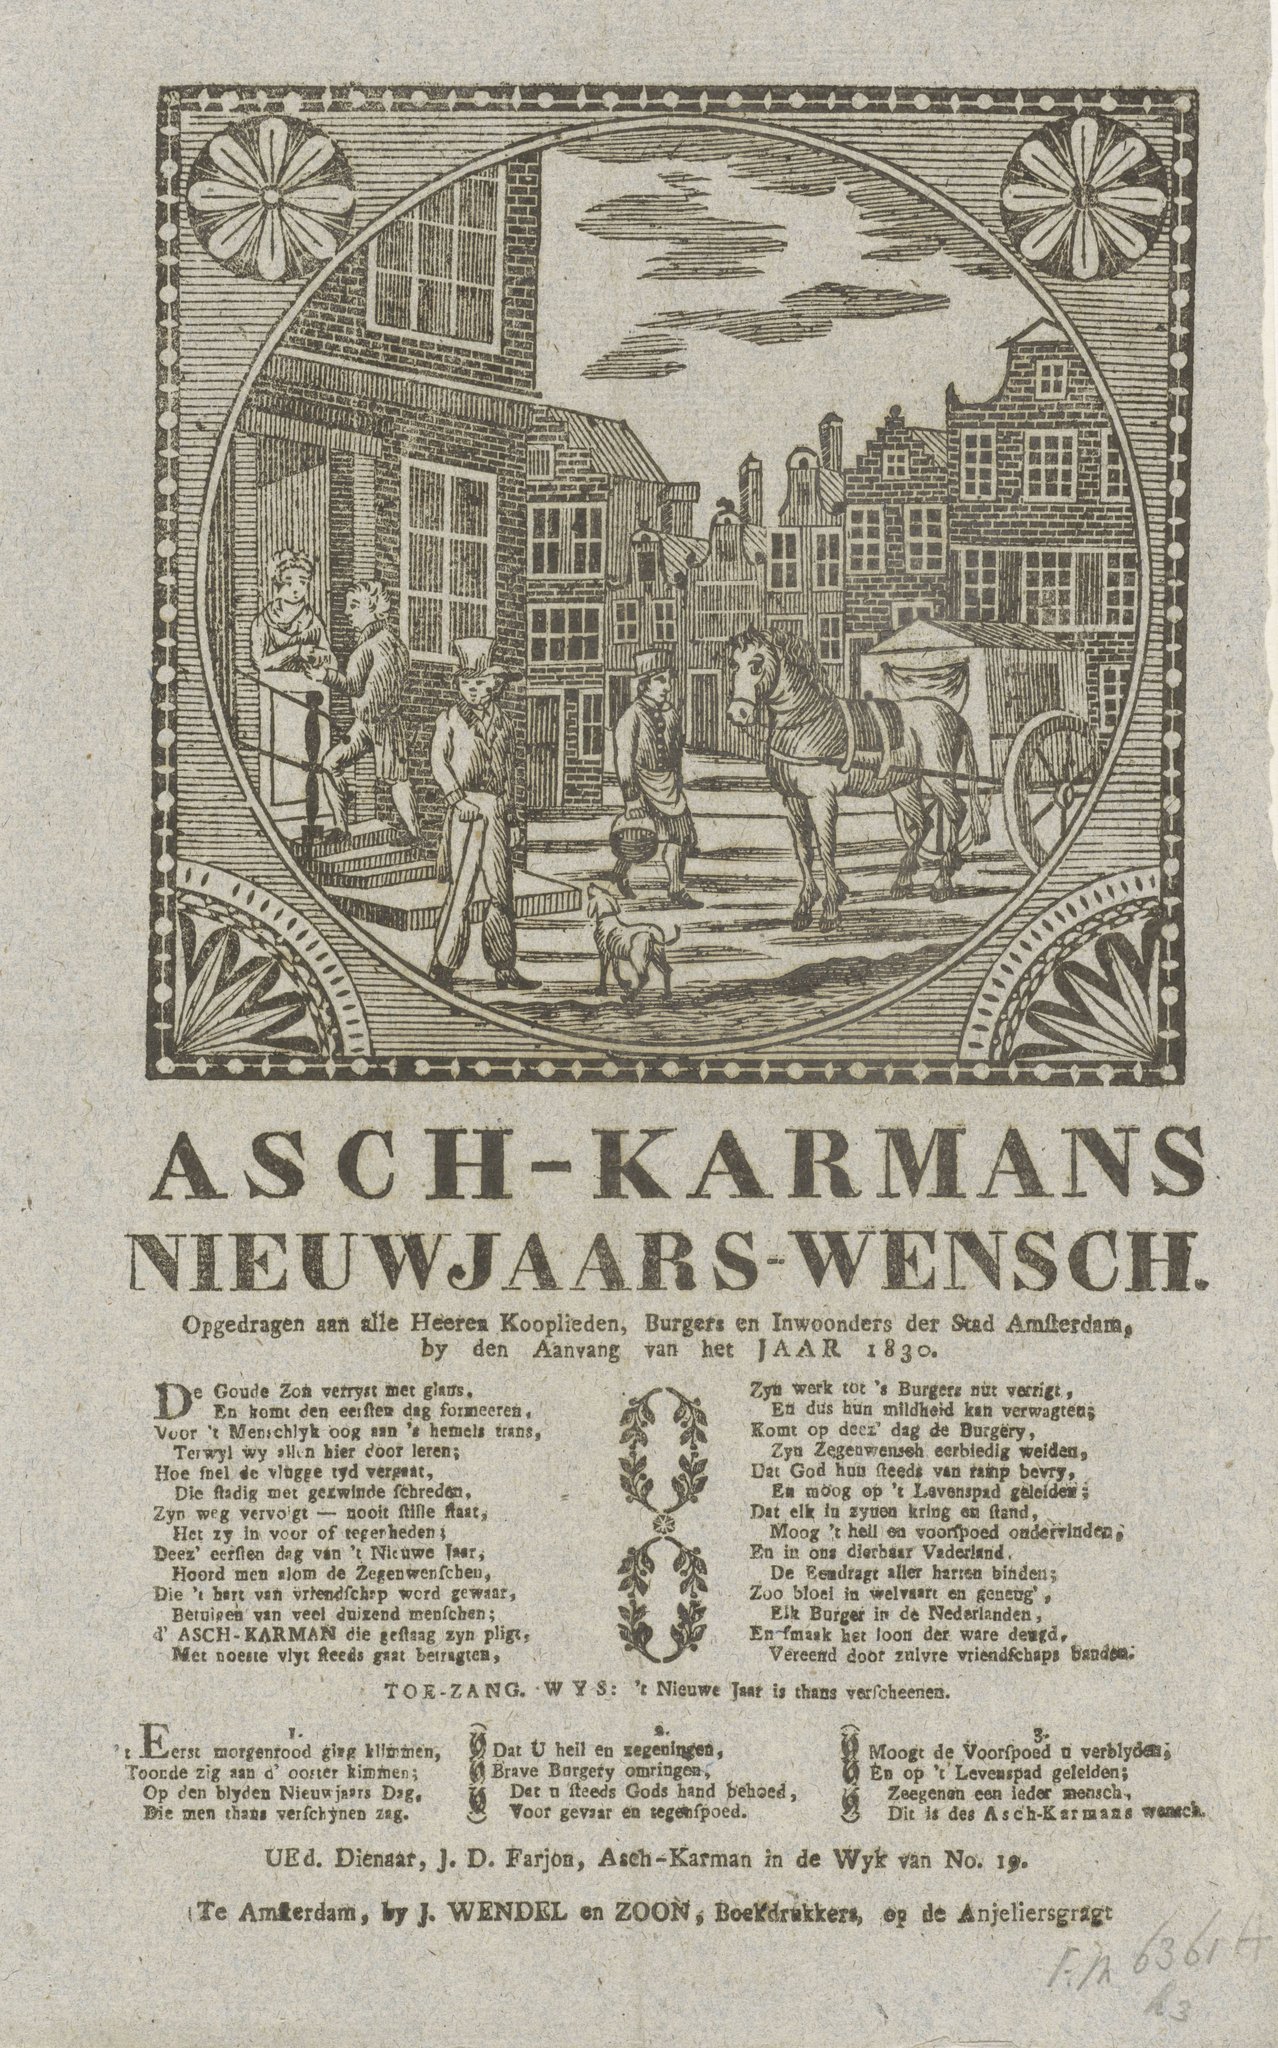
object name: new year card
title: Asch-Karmans Nieuwjaars-Wensch (...) 1830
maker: Anonymous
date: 1829-1830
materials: paper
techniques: letterpress printing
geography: netherlands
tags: public road - ii - ideal city, garbage collection, amsterdam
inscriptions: collector's mark: Lugt 2228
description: Nieuwjaarswens namens de askarrenmannen (karrenman of vuilnisman) te Amsterdam voor het jaar 1830. Gezicht in een straat te Amsterdam waar een man asemmers naar de kar draagt terwijl een andere man aan huis geld ophaalt. Onderaan een gedicht in twee kolommen en een lied in drie verzen. Namens J.D. Farjon, de askarreman van wijk no. 19.